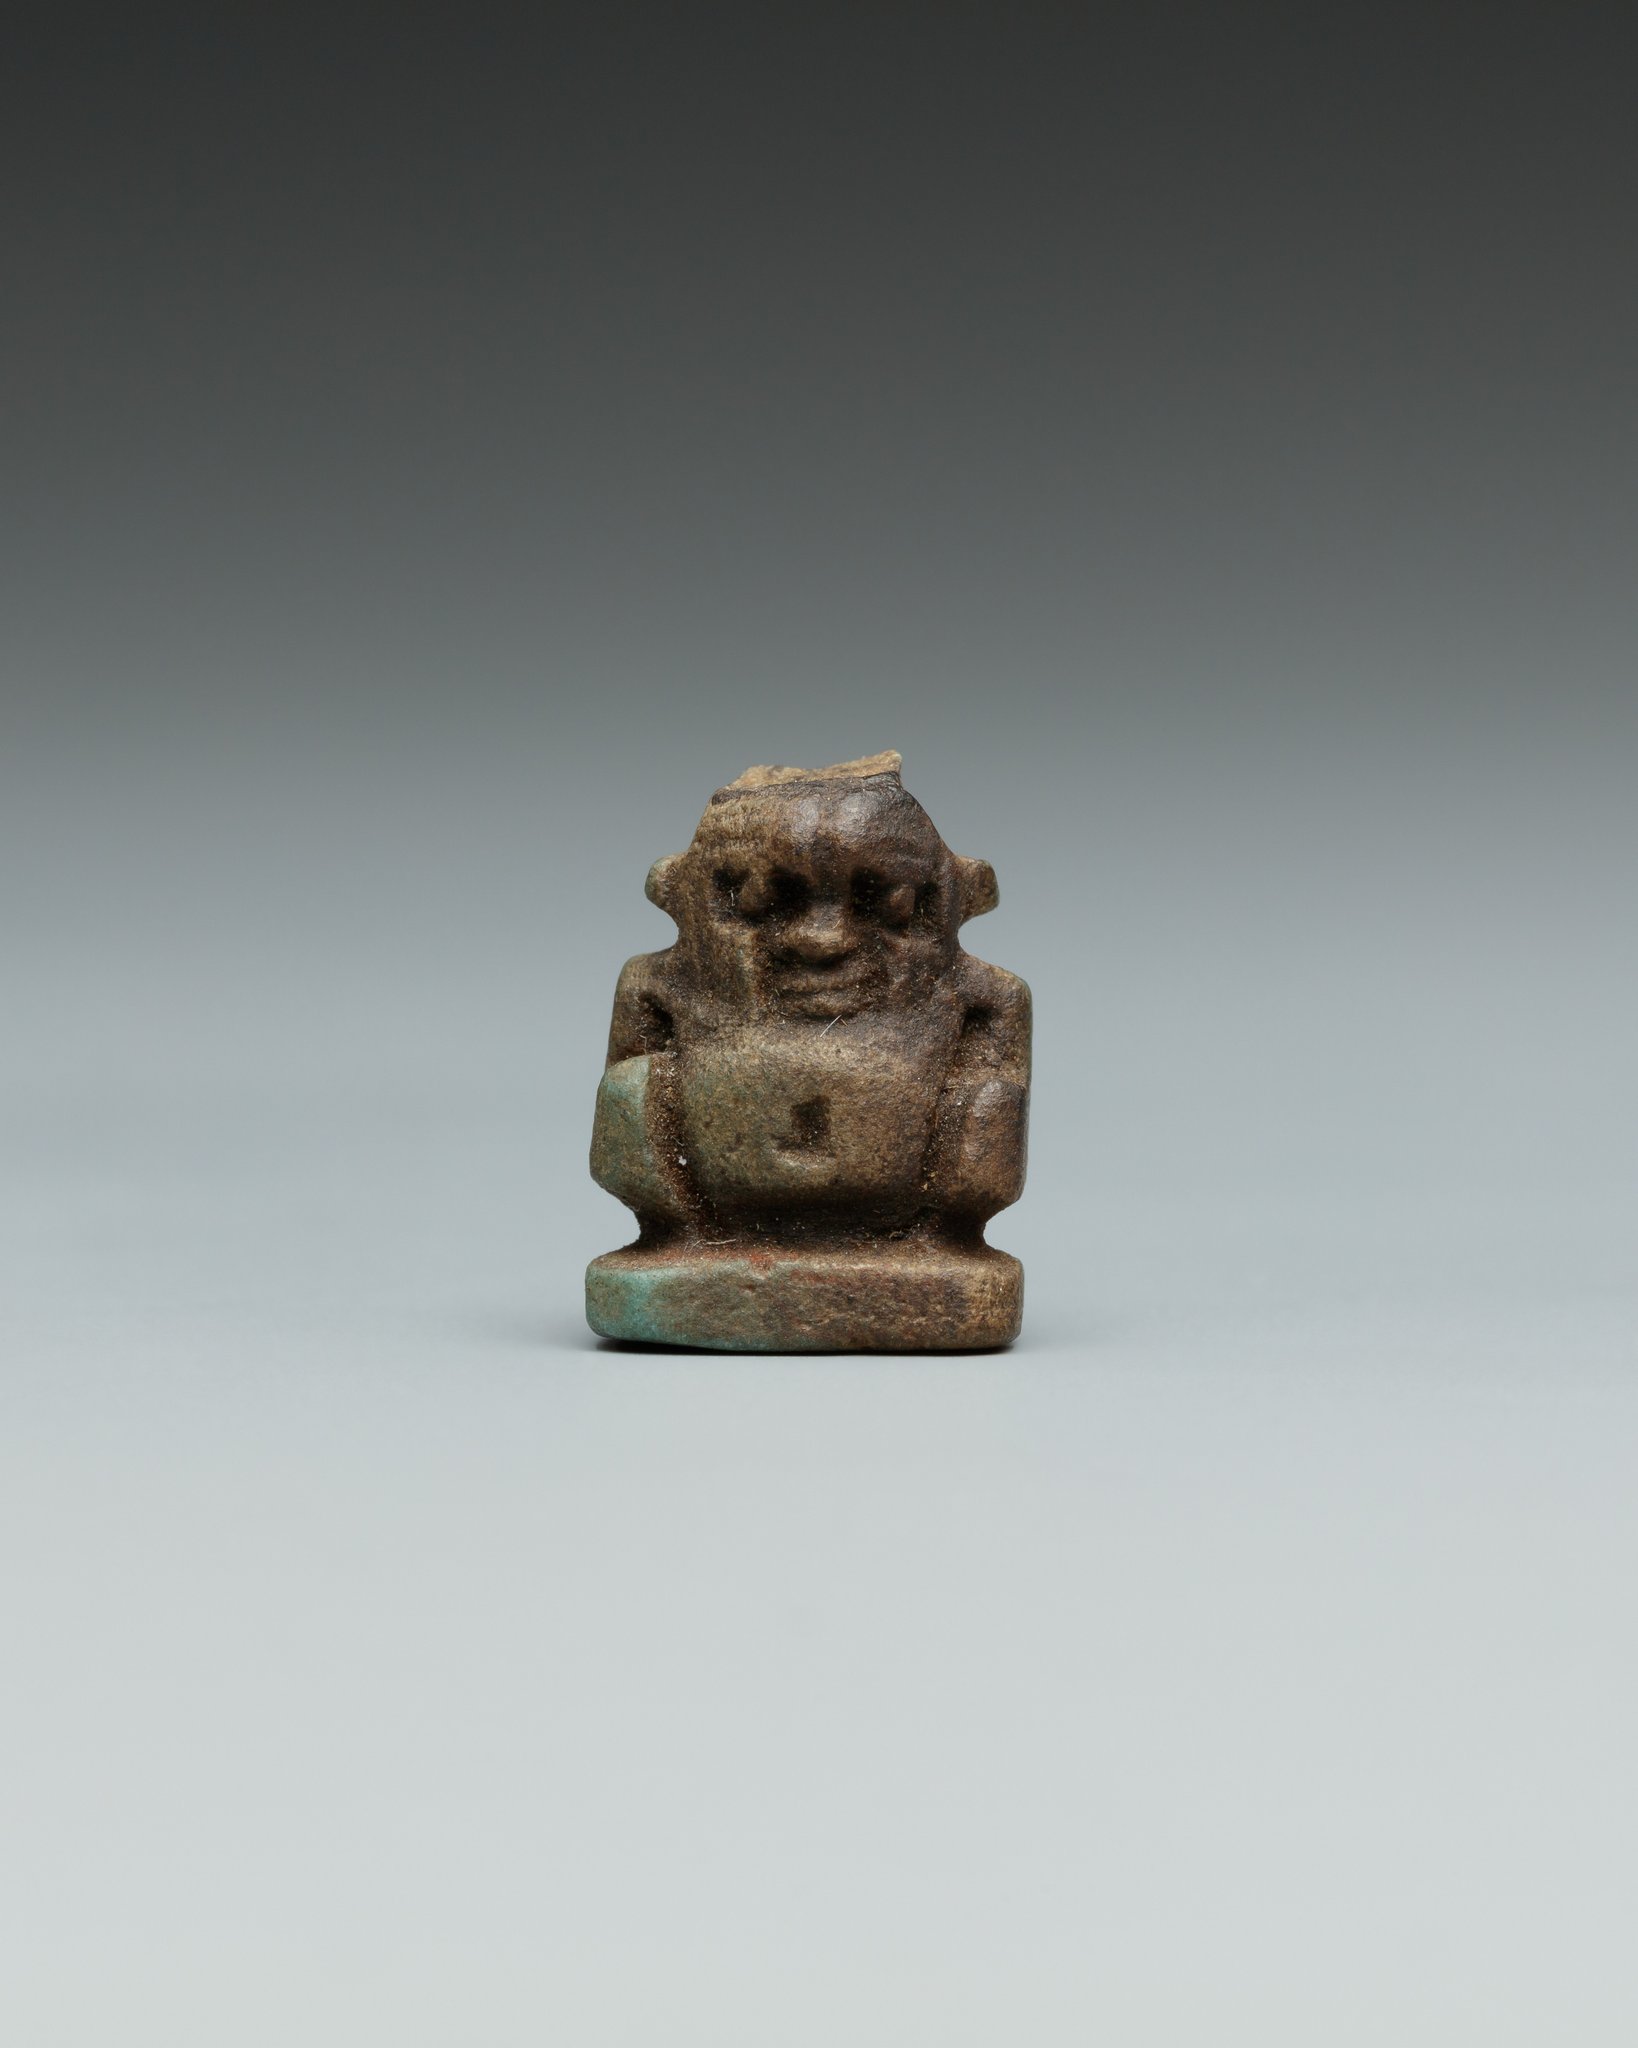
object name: amulet, be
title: Bes amulet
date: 664-630 BCE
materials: faience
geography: egypt